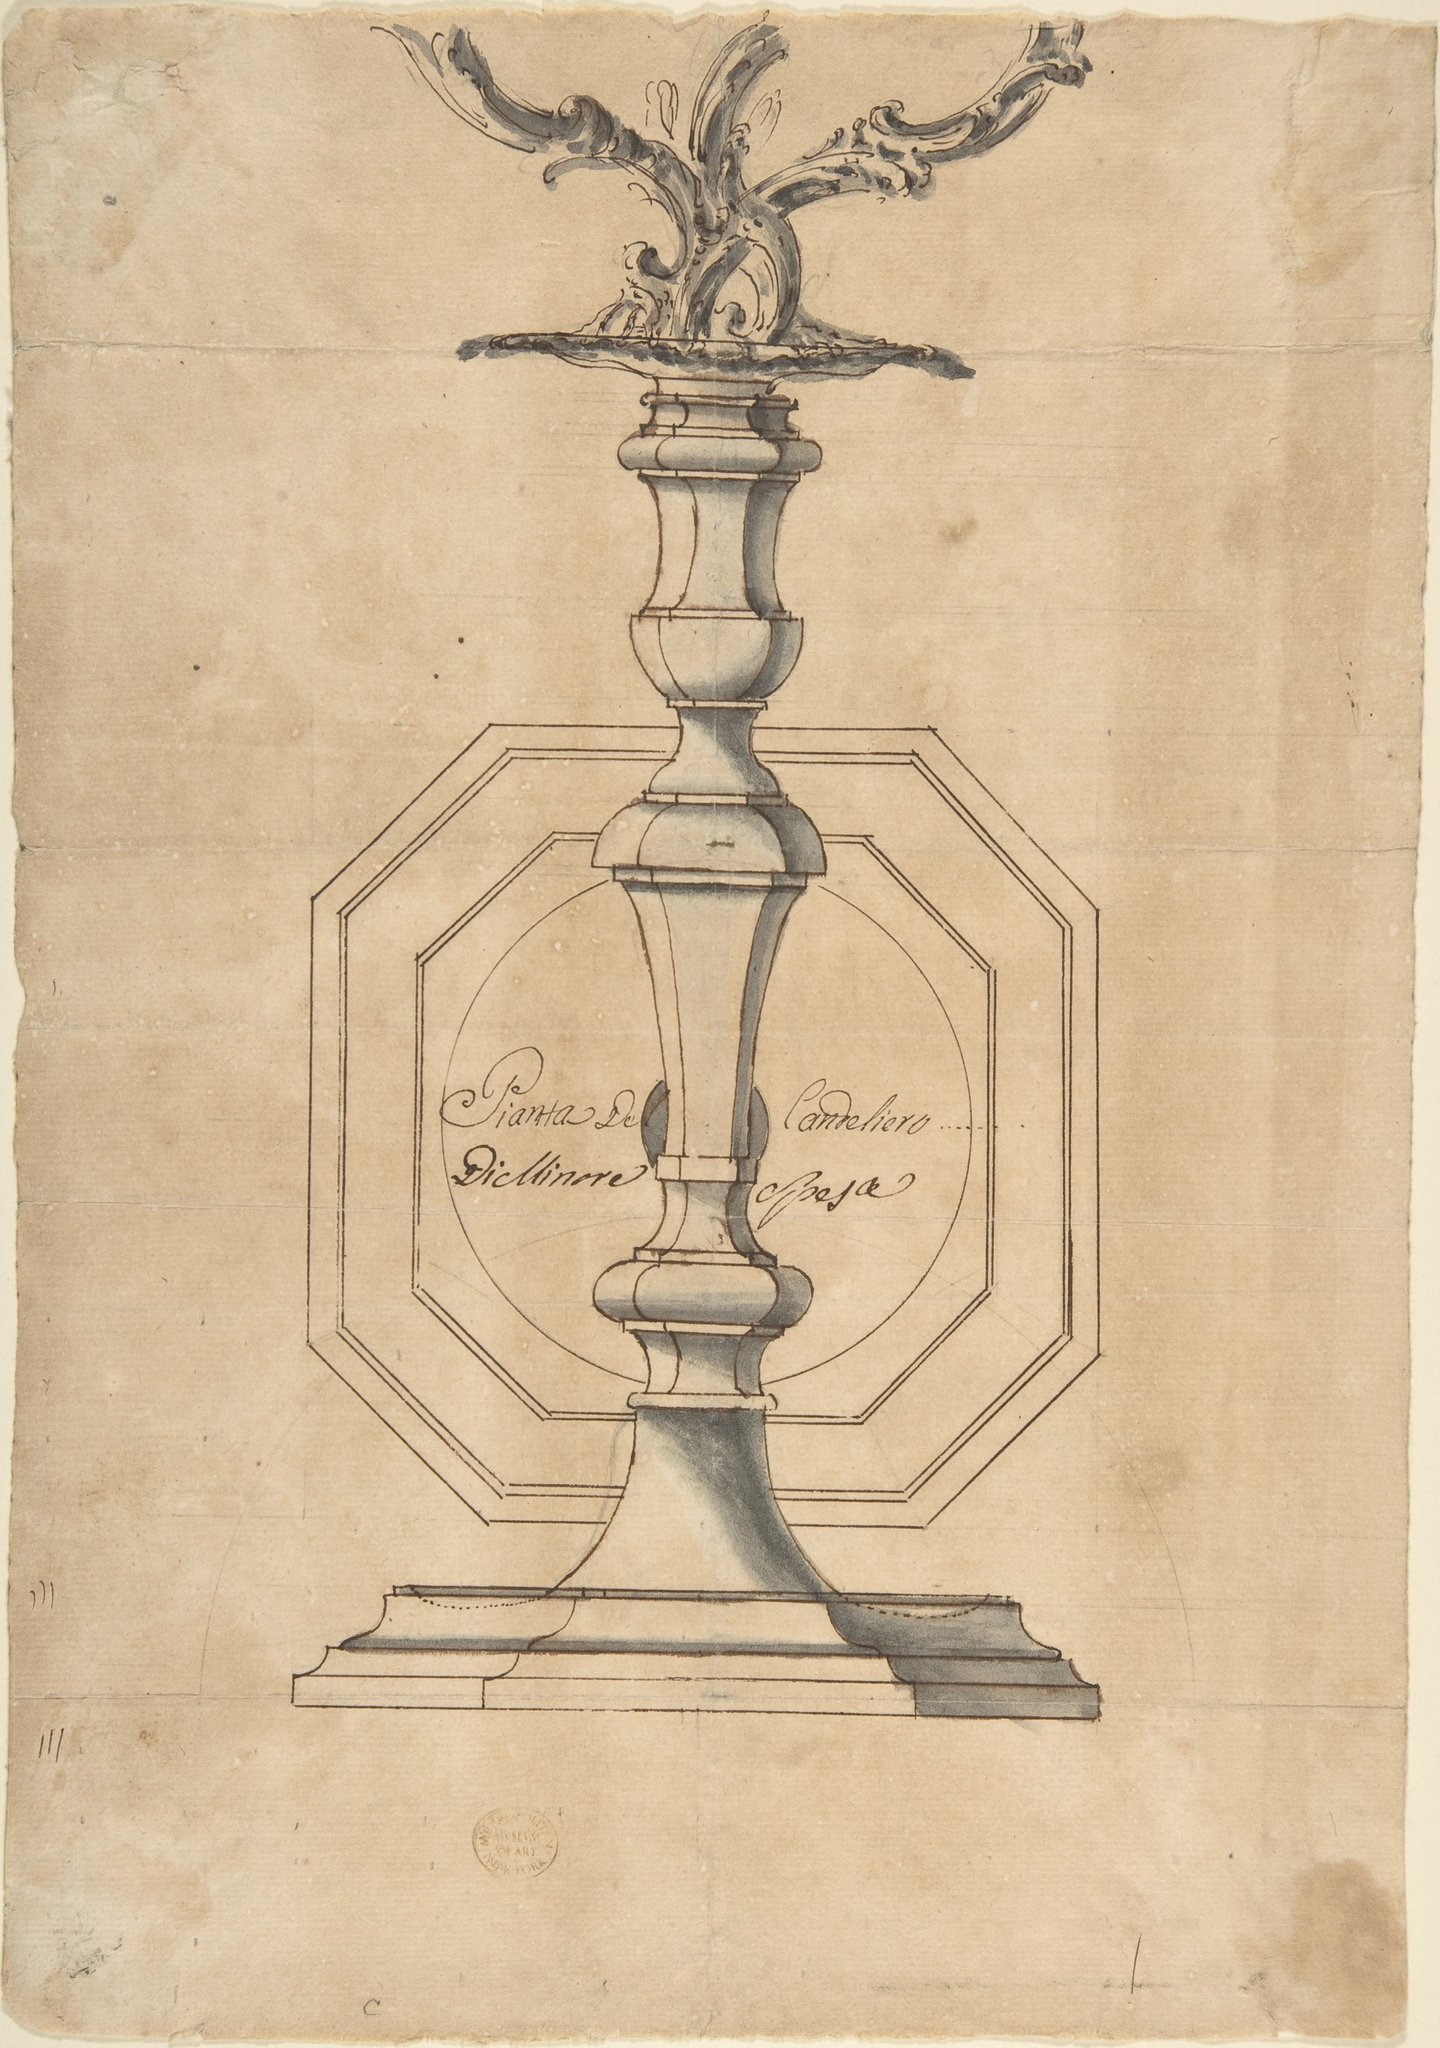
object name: drawing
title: Candlestick with Three Branches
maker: anonymous, italian, 18th century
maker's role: artist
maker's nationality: italian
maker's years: 1700-1800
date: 1701-1800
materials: ink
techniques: brush, pen, wash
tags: candlesticks